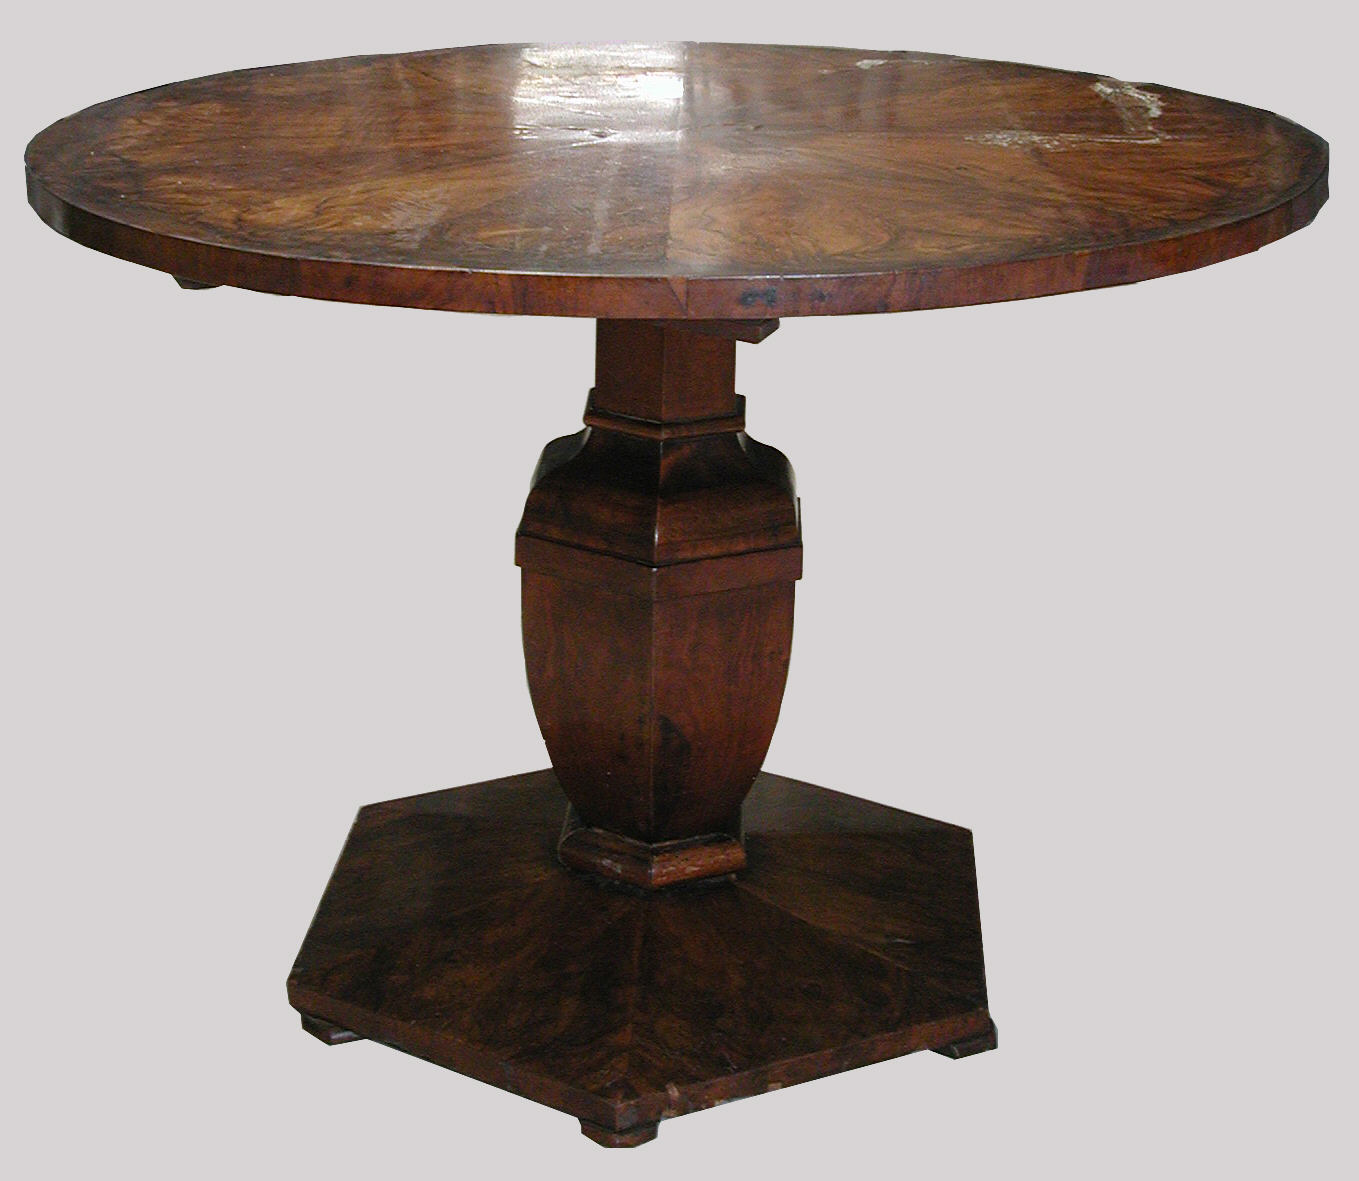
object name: table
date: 1825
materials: iron, wood, steel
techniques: veneering